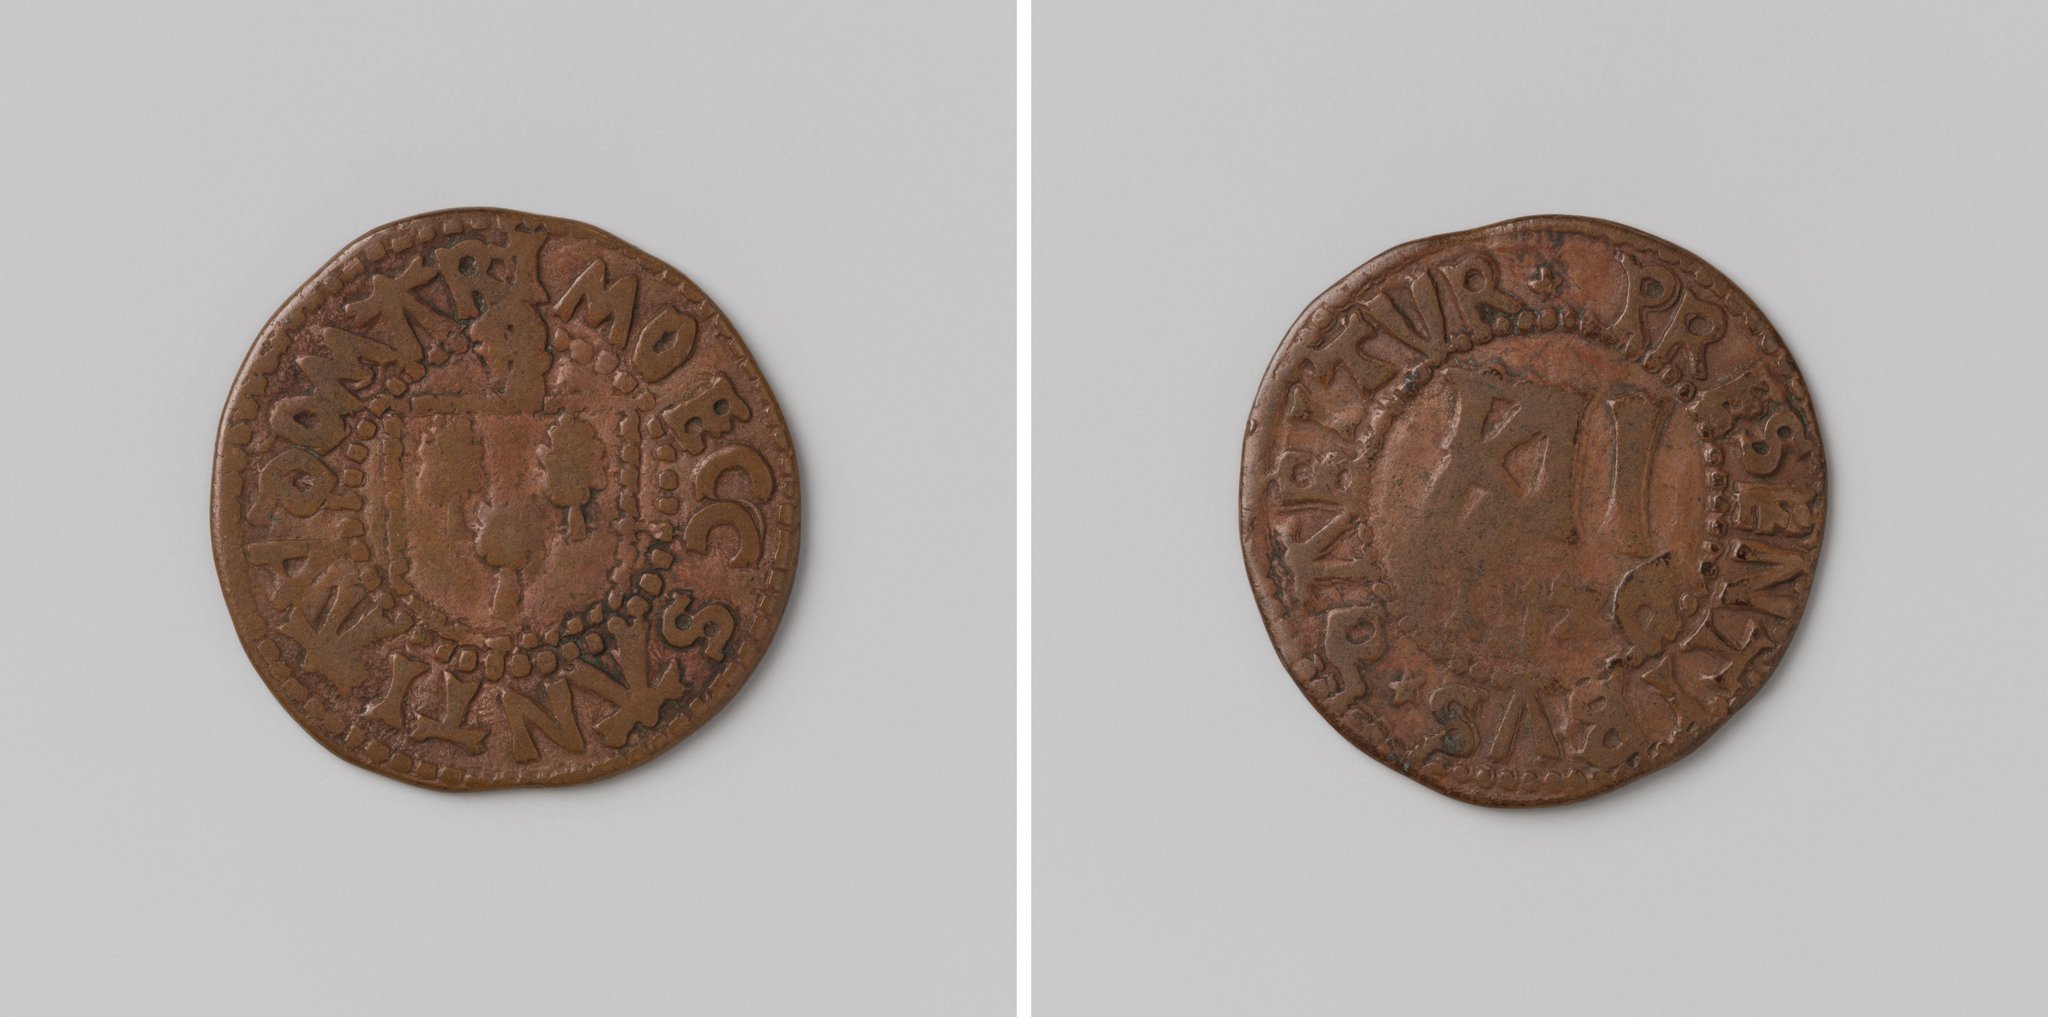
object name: devotional medal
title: Kerk van St. Omer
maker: Anonymous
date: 1426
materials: copper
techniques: striking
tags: saint-omer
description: Koperen penning. Voorzijde: wapenschild op bisschopsstaf binnen omschrift. Keerzijde: monogram boven jaartal binnen omschrift